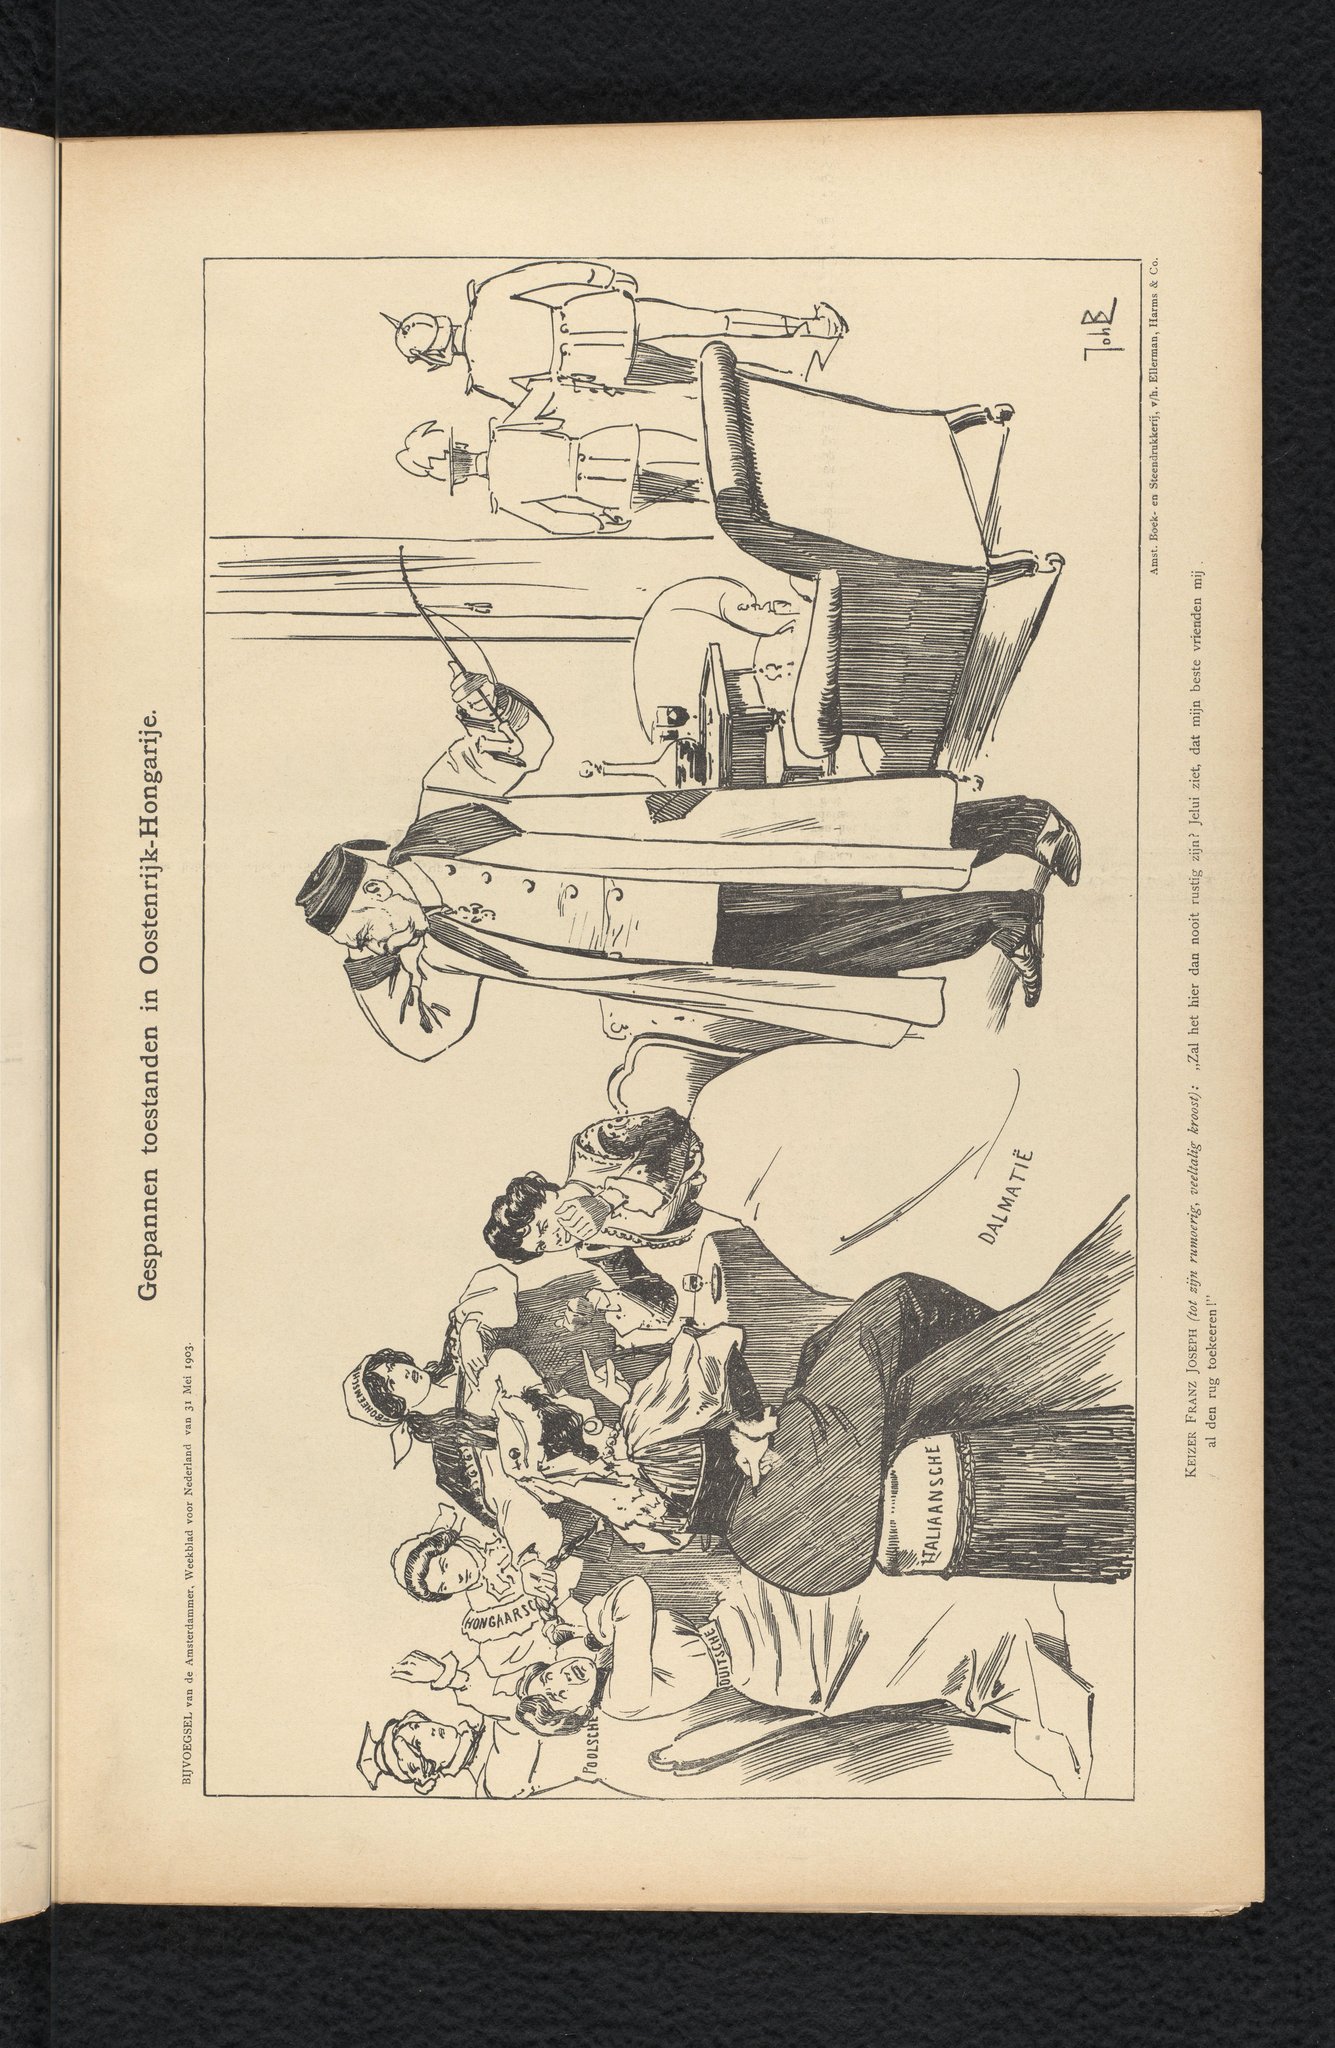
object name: cartoon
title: Gespannen toestanden in Oostenrijk-Hongarije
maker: johan braakensiek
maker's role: draughtsman, print maker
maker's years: 1858-1940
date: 1903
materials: paper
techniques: lithograph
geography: amsterdam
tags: vienna, wilhelm ii (keizer van duitsland), father with daughter(s) (father-love), fighting, political caricatures and satires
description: Keizer Franz Jozef I maant zijn onderling vechtende dochters (Bohemen, Roemenië, Dalmatië etc.) tot rust. Zijn vrienden, koning Victor Emanuel III van Italië en keizer Wilhelm II verlaten de onrustige kamer.